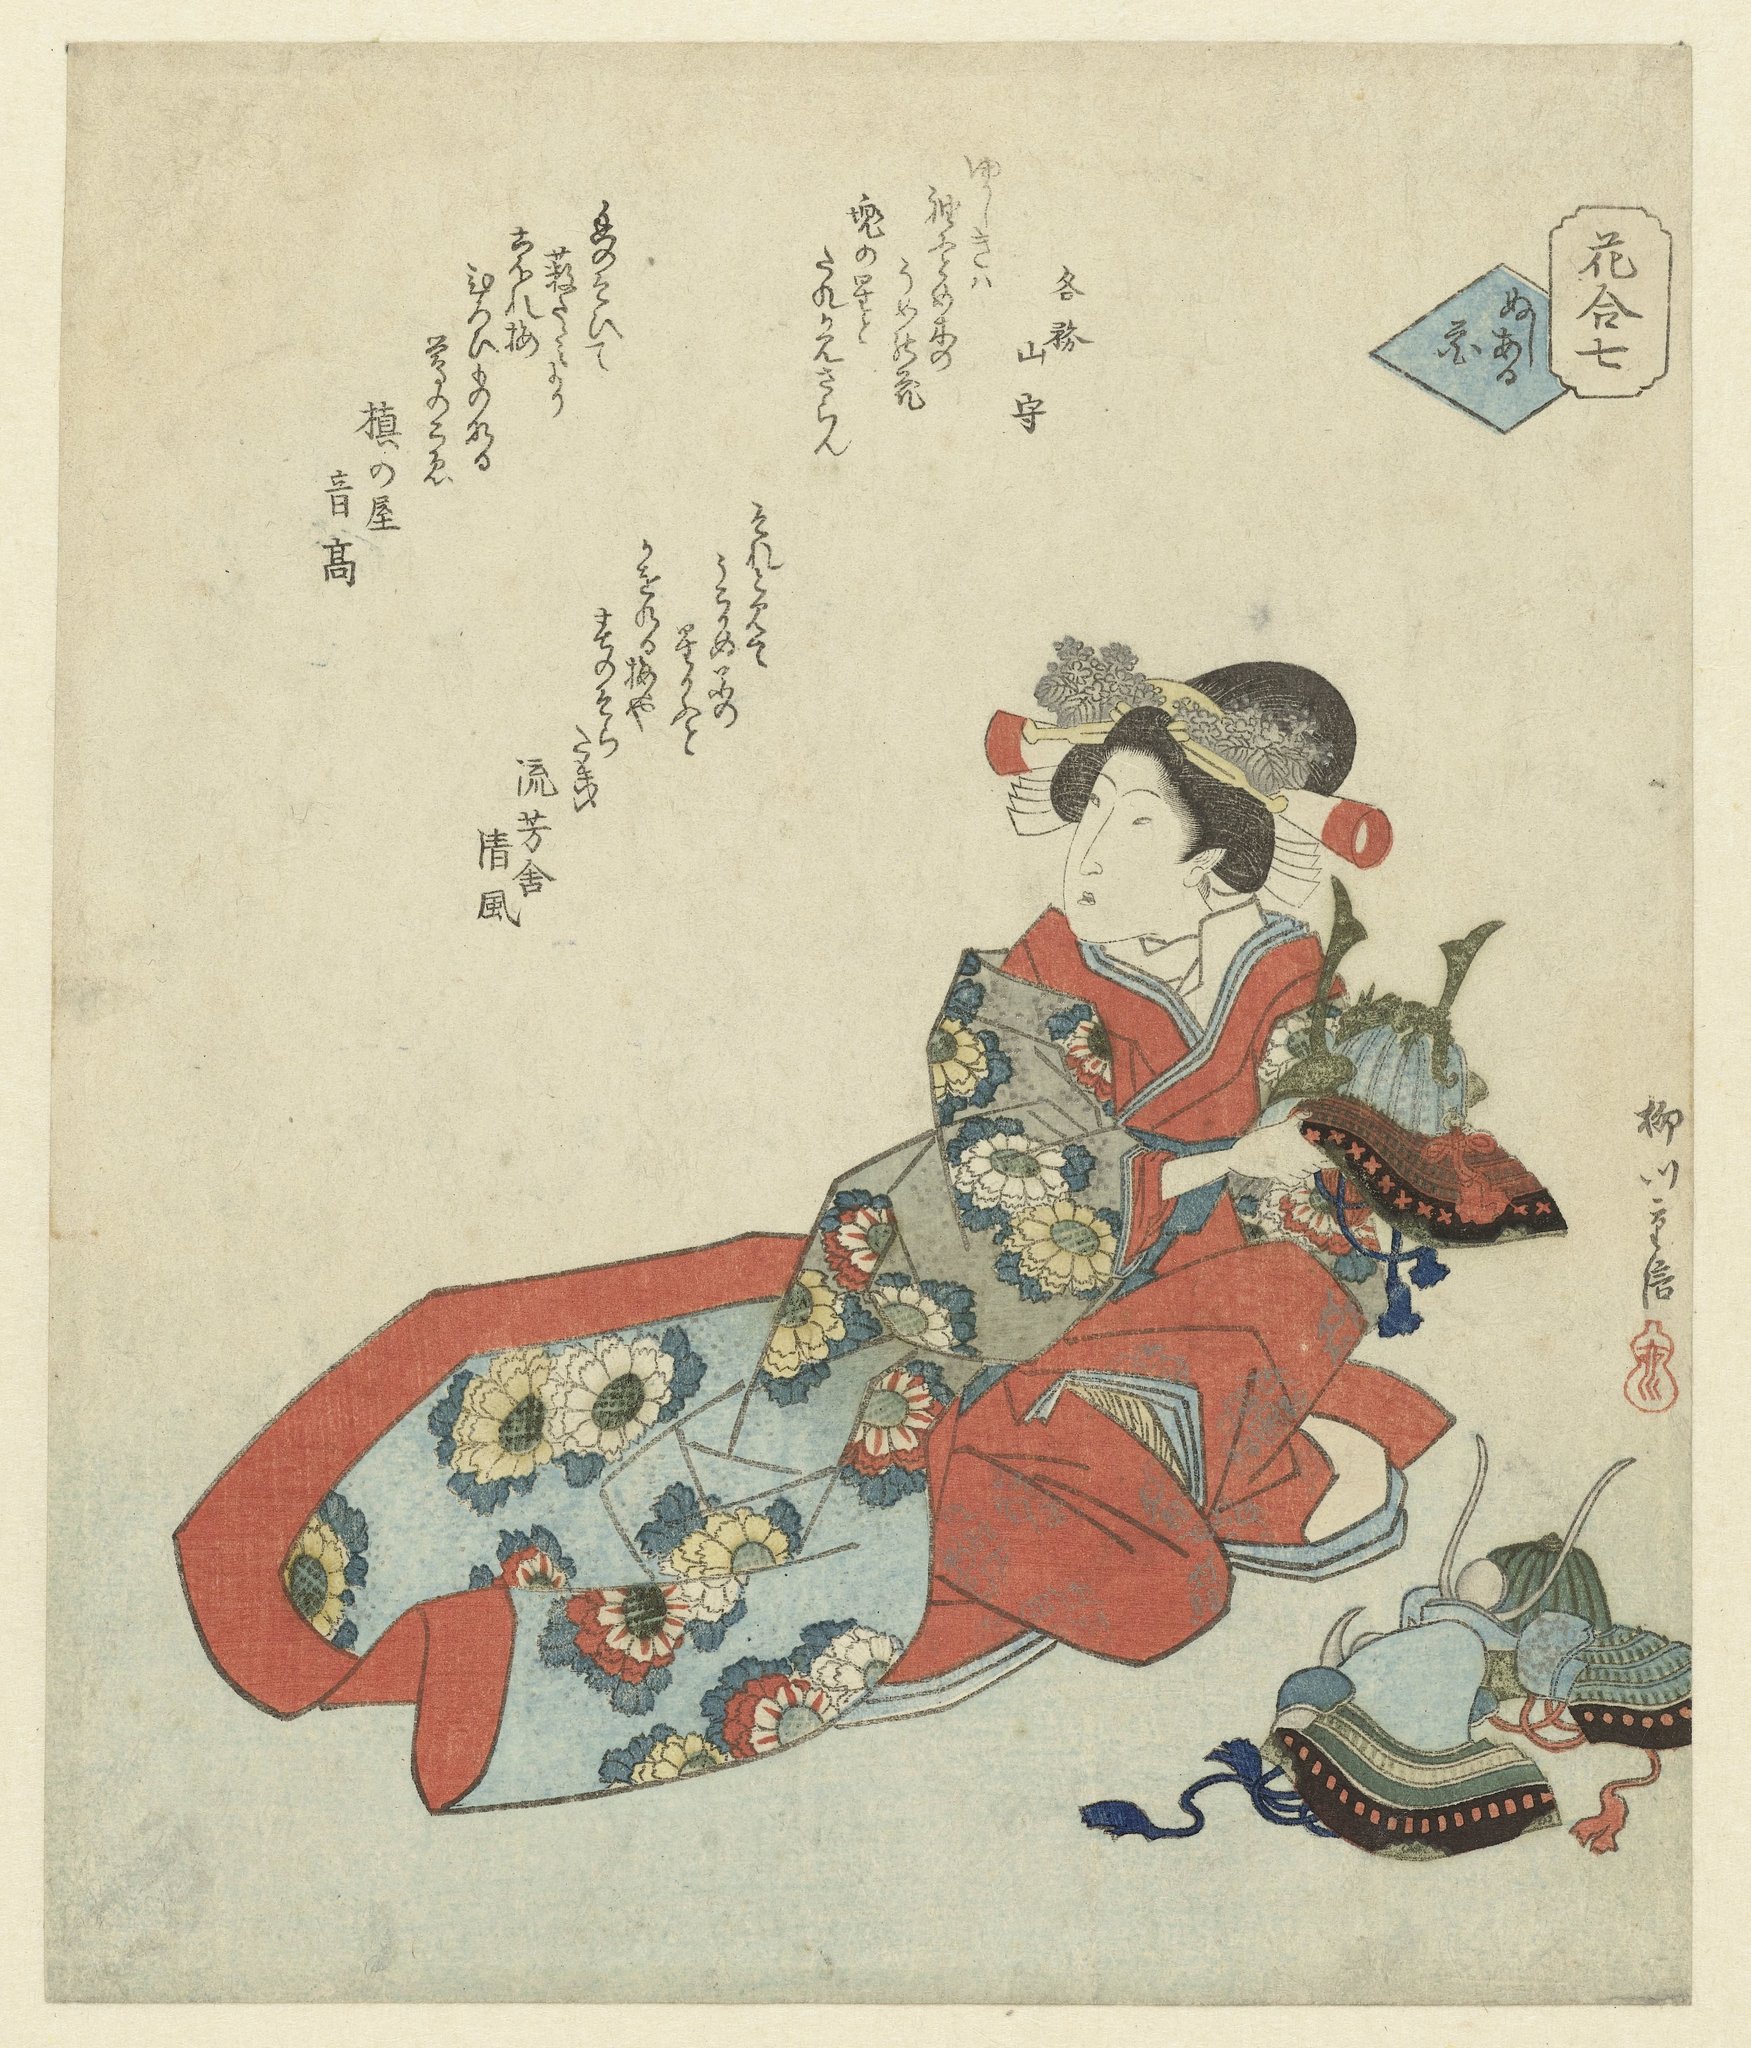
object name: surimono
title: A Comparison of Flowers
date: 1825-1830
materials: paper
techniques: woodcut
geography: japan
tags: helmet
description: Een surimono is een luxe uitgevoerde prent waarop beeld met één of meerdere gedichten gecombineerd is. Bij het drukken van een surimono werd vaak gebruik gemaakt van dikker papier, blinddruk en metaal pigmenten, zoals koper- en zilverpoeder. De prenten werden vaak in opdracht van dichters gemaakt en als exclusief geschenk aan vrienden en relaties gegeven.